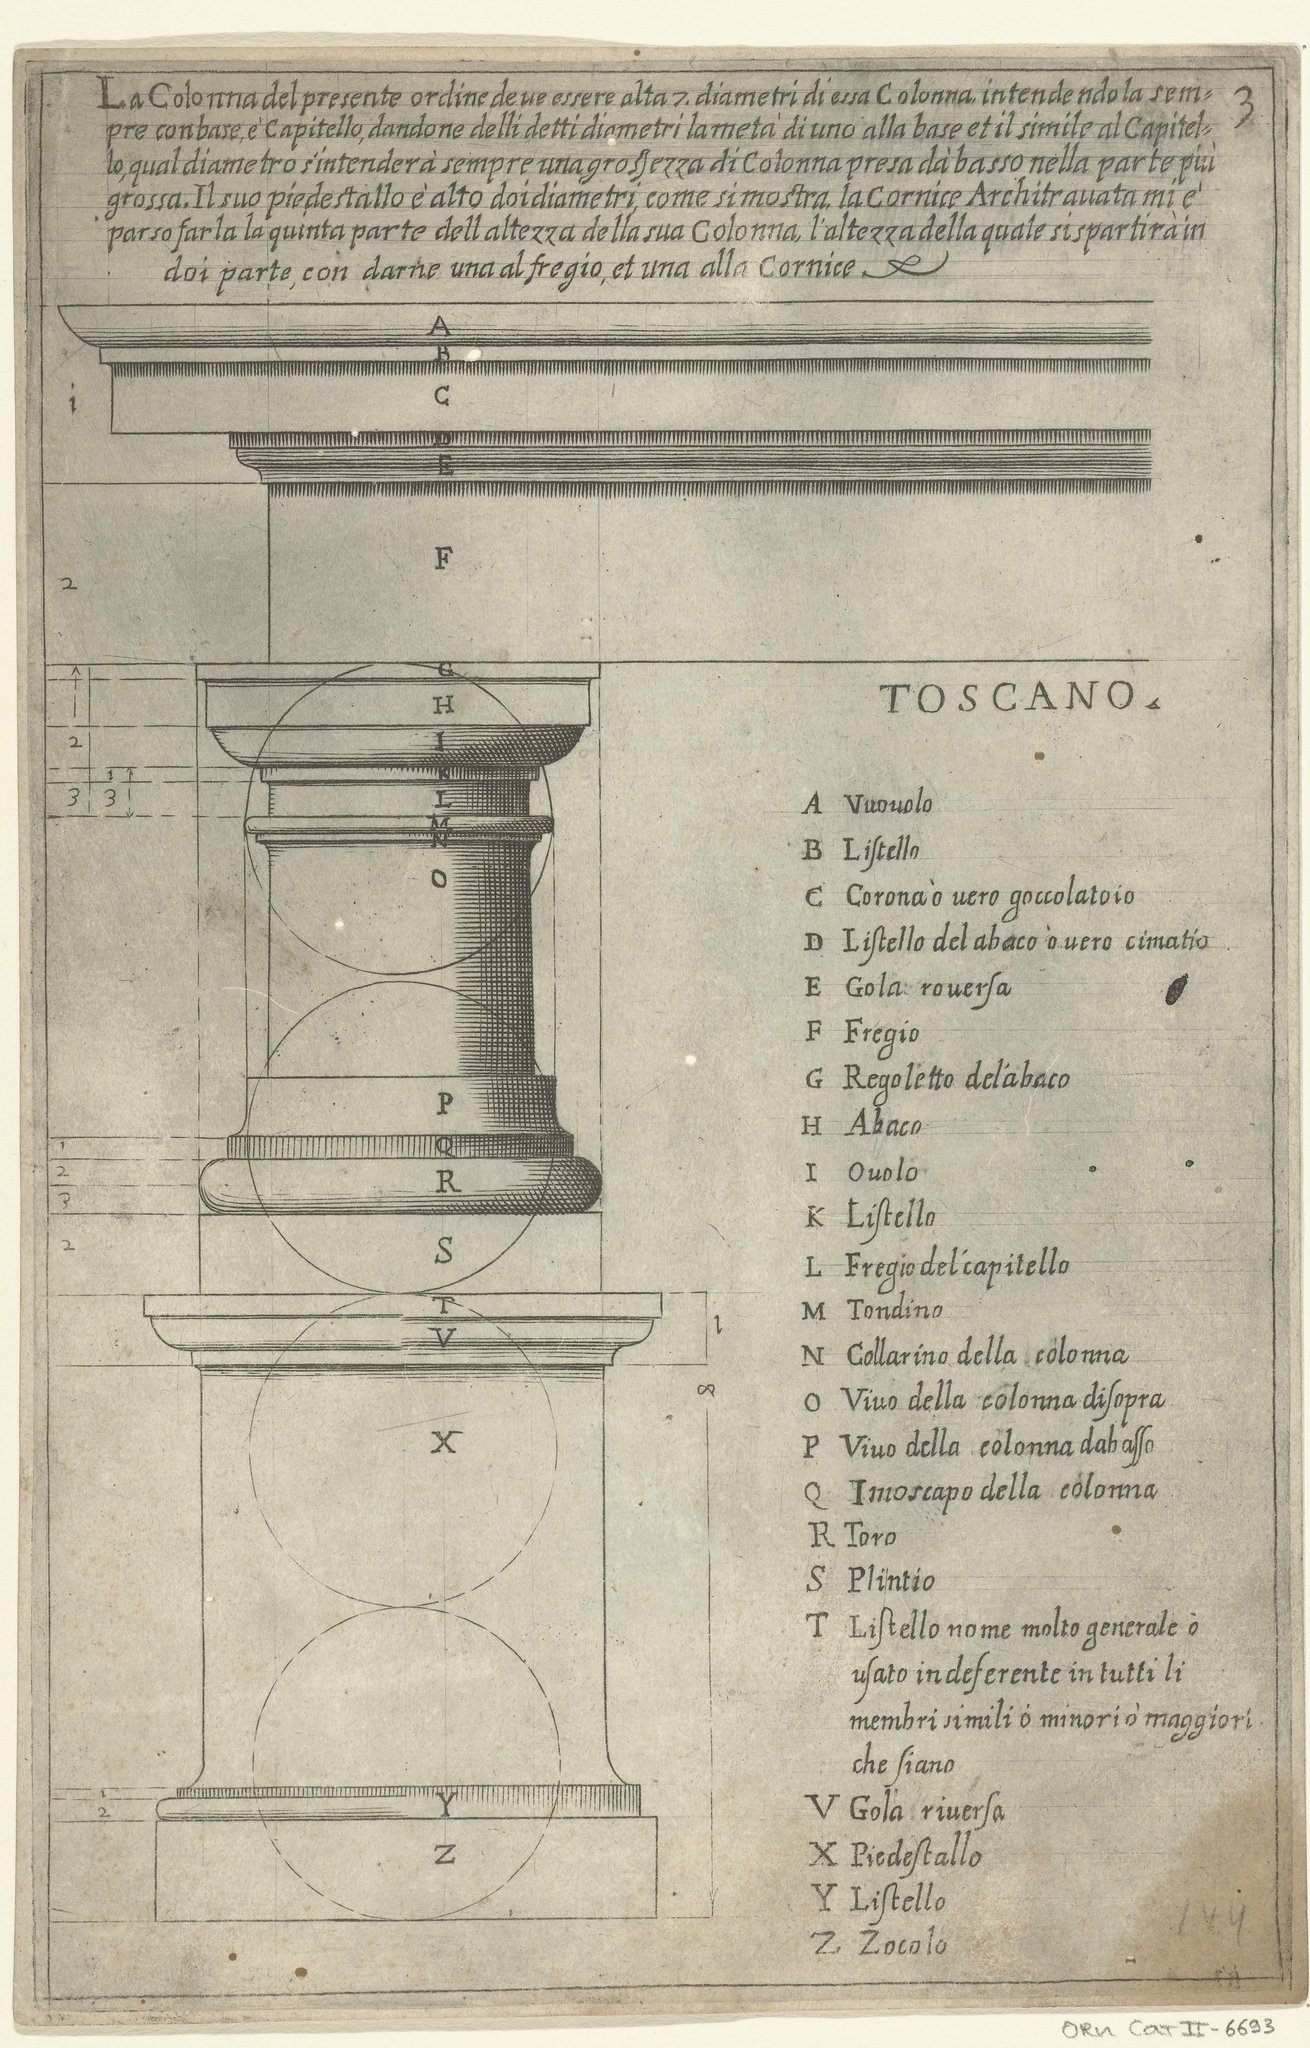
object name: print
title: Toscaans voetstuk, basement, zuil, kapiteel en hoofdgestel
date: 1636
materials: paper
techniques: engraving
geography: italy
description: Bovenaan staat uitleg, rechtsonder een lijst van de aangeduide onderdelen (A-Z). Uit eerste editie.